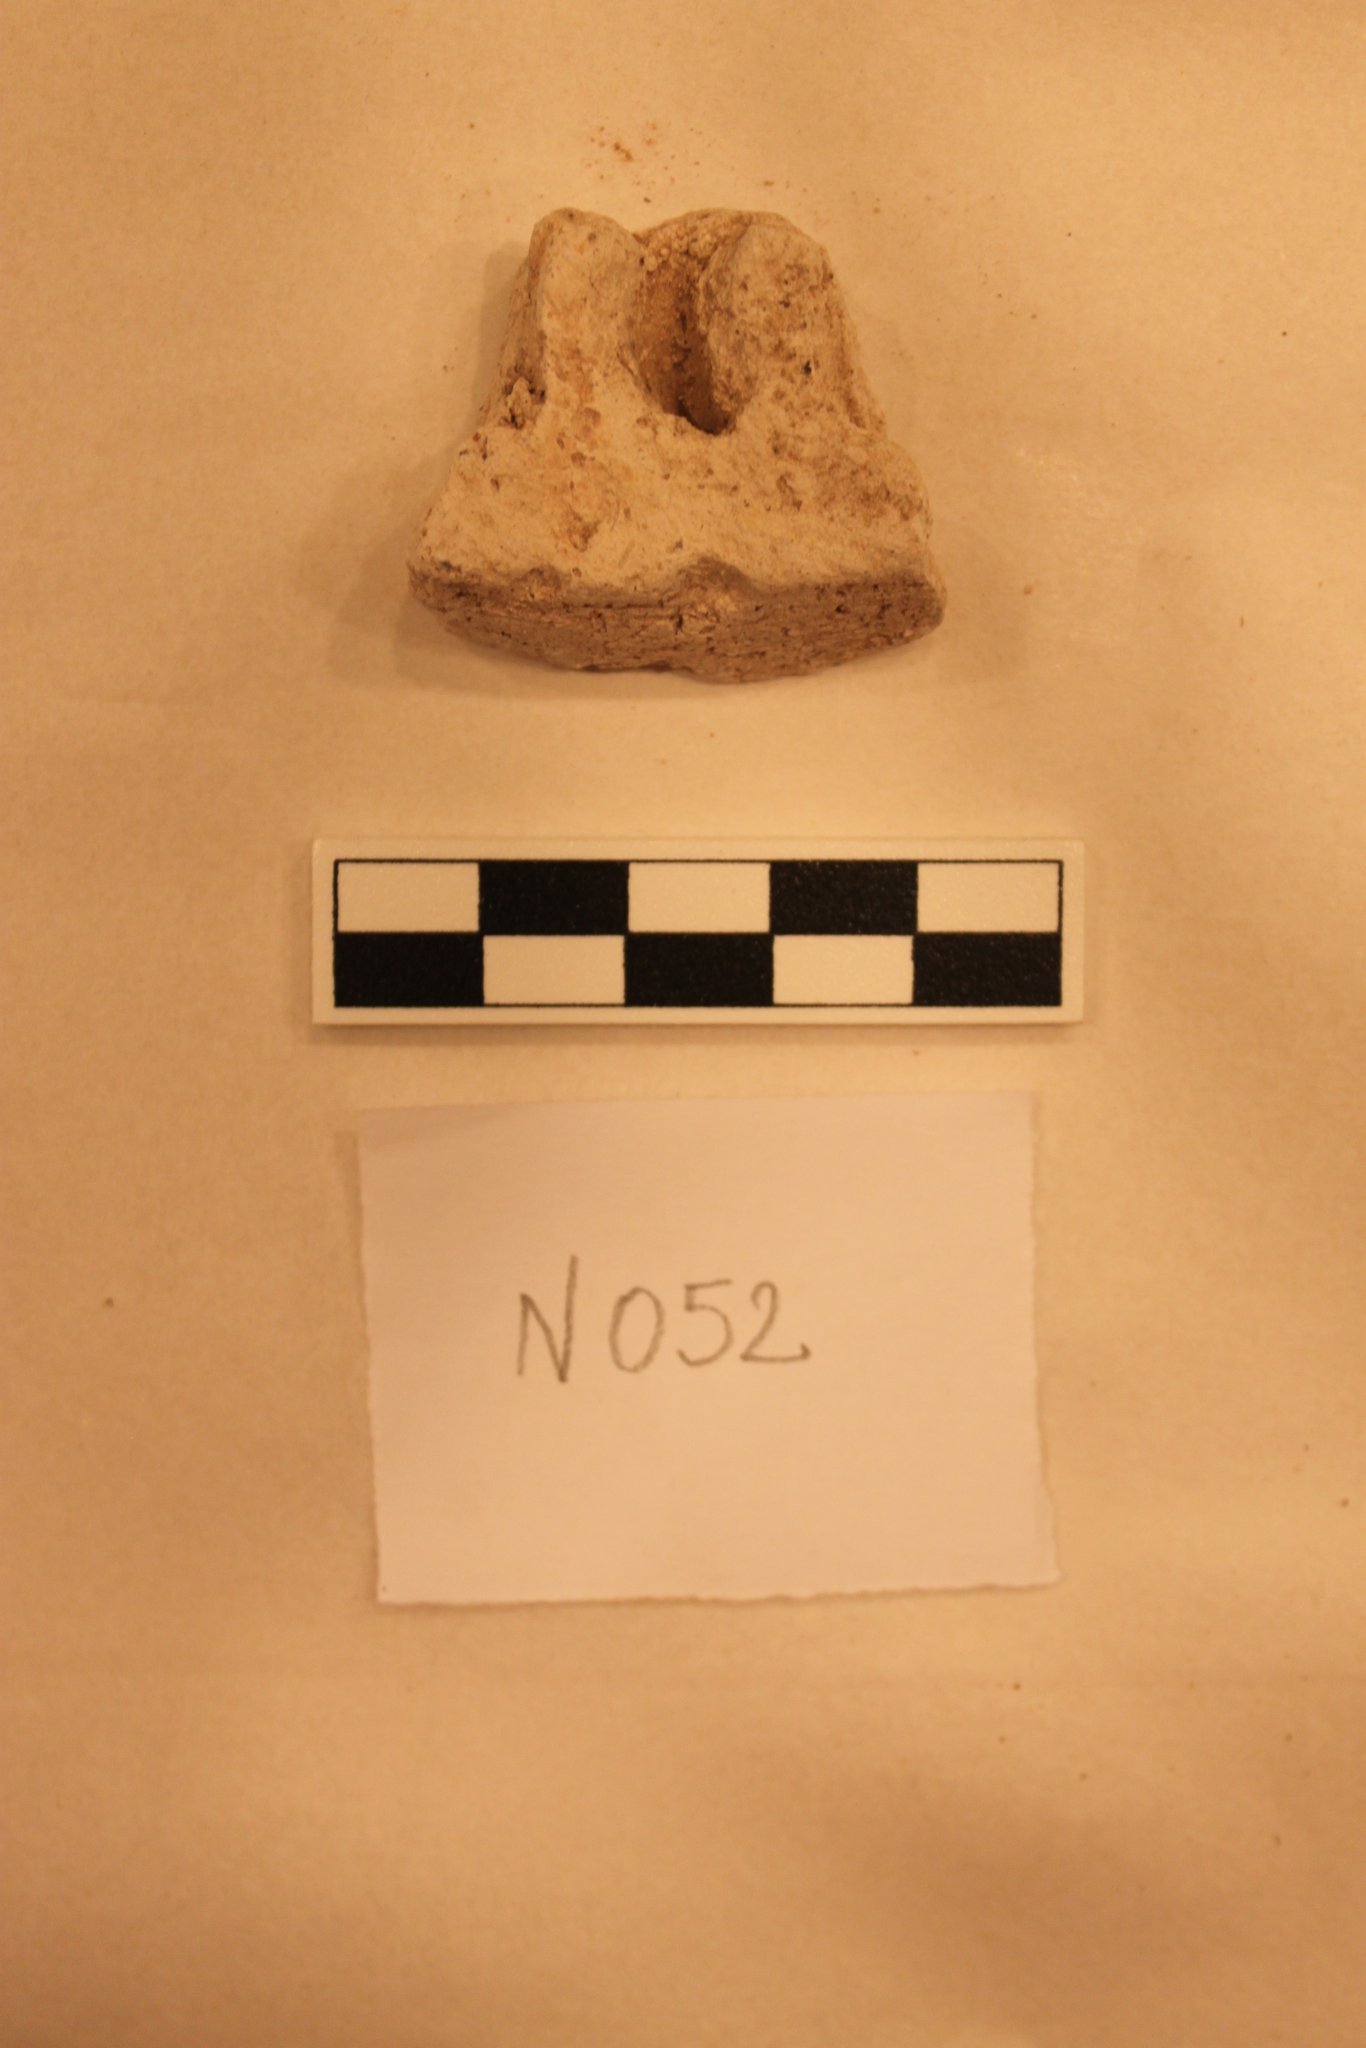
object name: fragment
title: Stucco Fragment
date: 701-1200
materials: plaster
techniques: carving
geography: iran